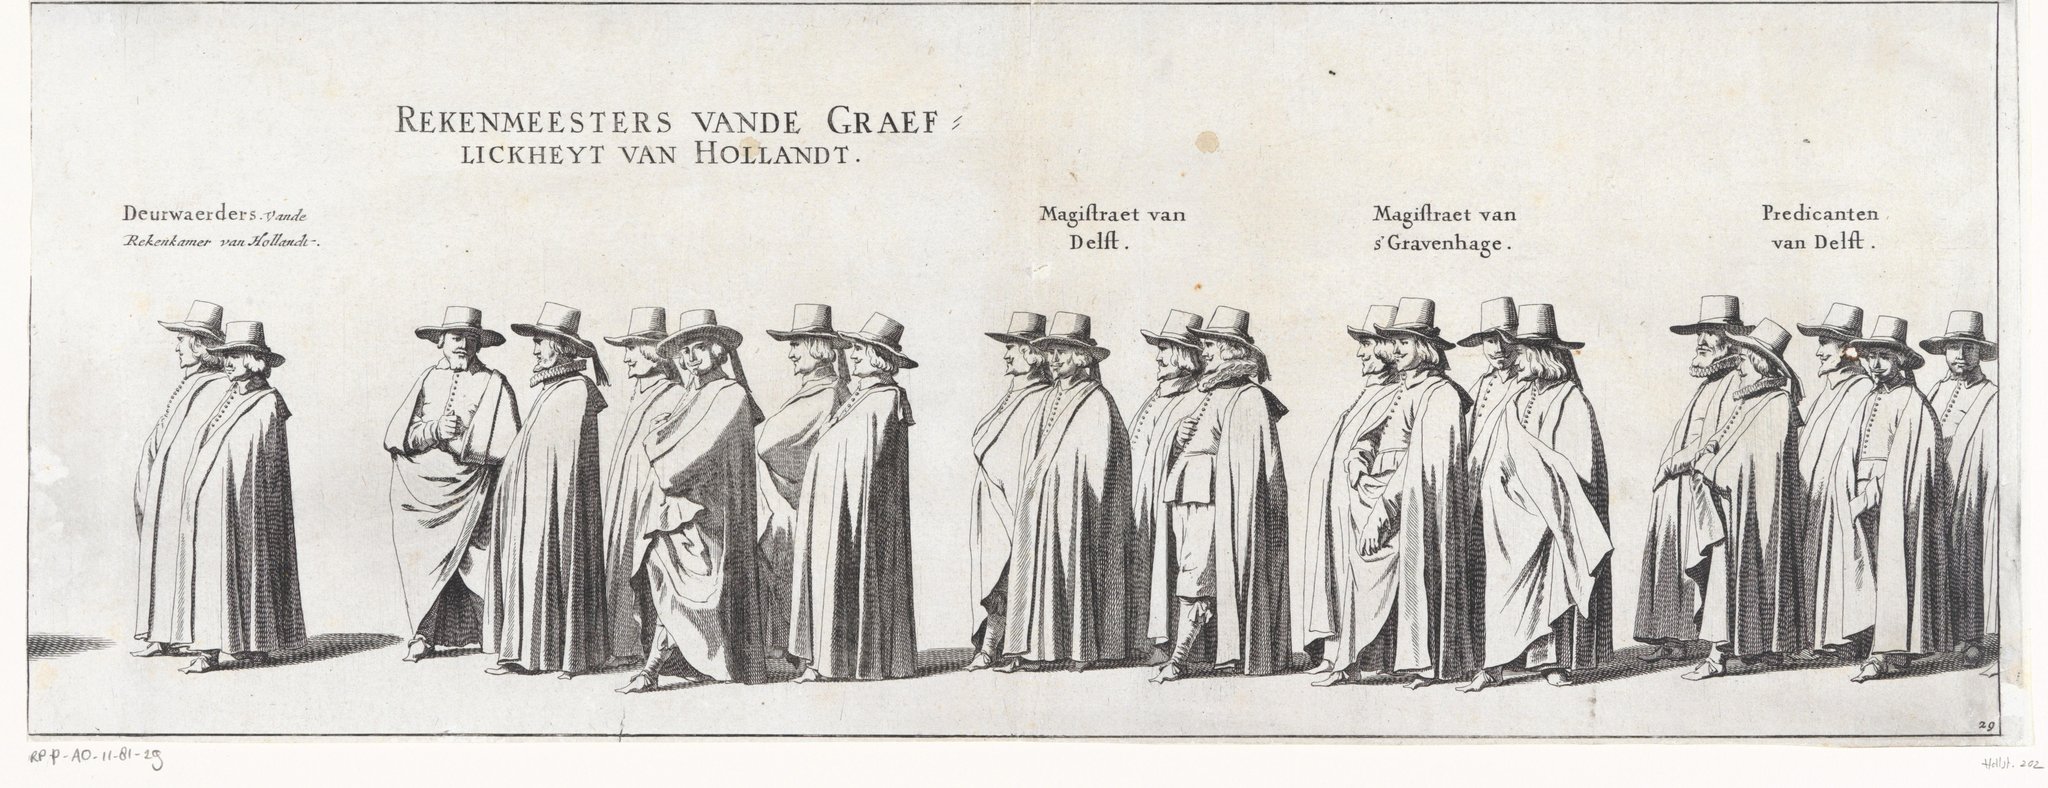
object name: print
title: De begrafenisstoet van Frederik Hendrik (plaat nr. 29), 1647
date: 1651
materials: paper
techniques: engraving, etching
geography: the hague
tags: cortege, funeral procession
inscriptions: collector's mark: Lugt 2228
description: De begrafenisstoet van stadhouder Frederik Hendrik te 's-Gravenhage op 10 mei 1647. Plaat nr. 29 met een deel van de stoet met rekenmeesters en vertegenwoordigers en predikanten van verschillende steden, boven de personen staat hun functie. Onderdeel van een serie van 30 platen en 20 tekstbladen, bedoeld om aan elkaar geplakt te worden.